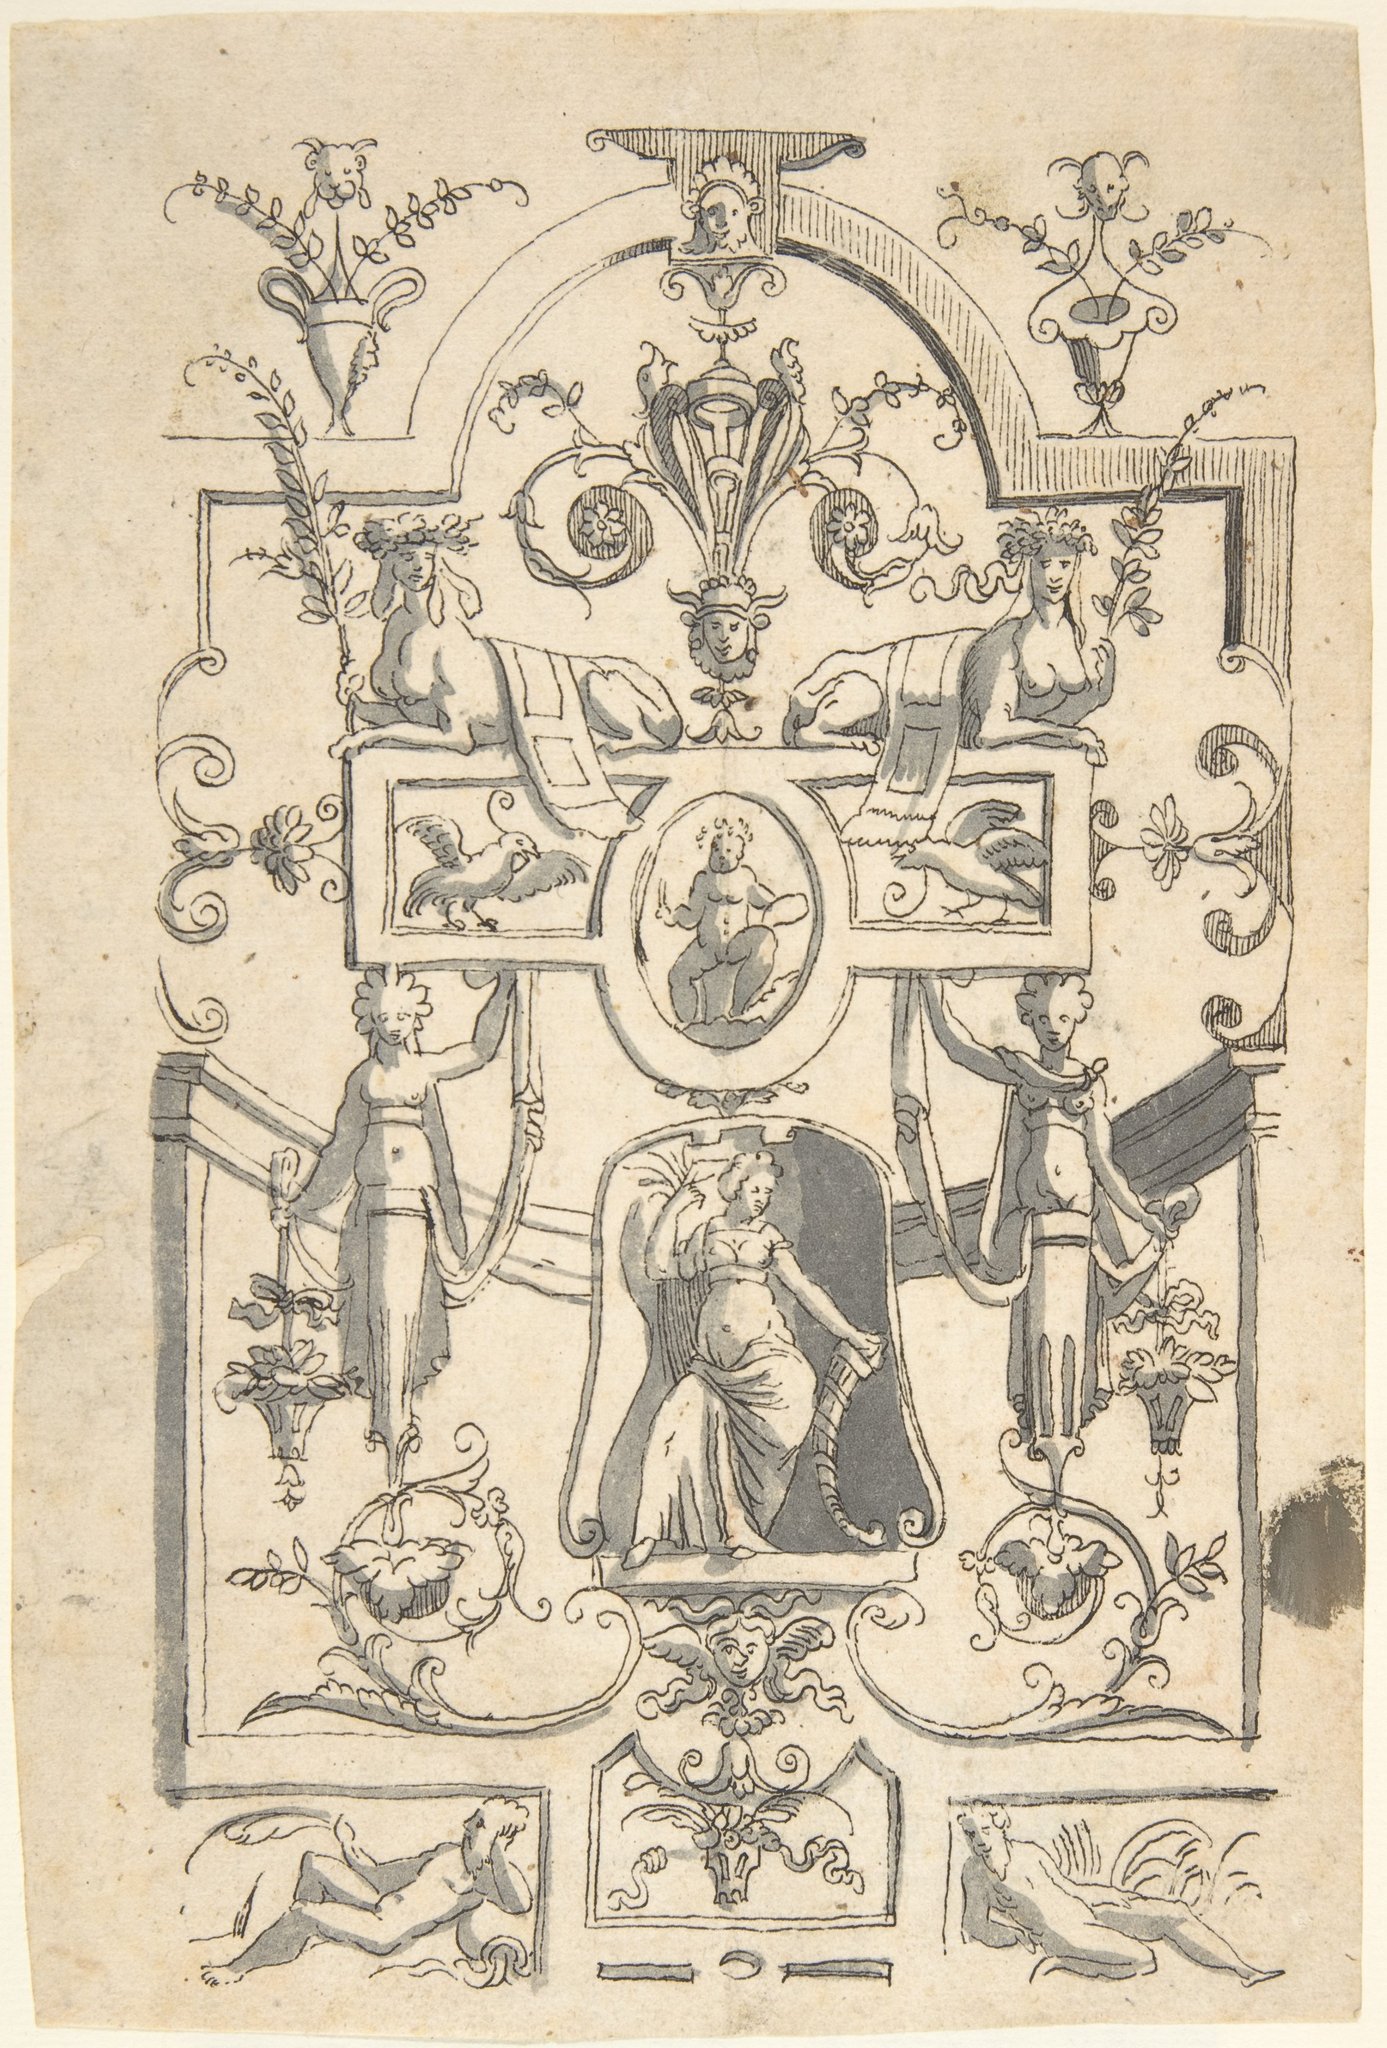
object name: ornament architecture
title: Candelabra Grotesque with a Female Figure in a Niche and Two Sphinxes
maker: anonymous, italian, 16th century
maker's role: artist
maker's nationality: italian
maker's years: 1500-1600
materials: ink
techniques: brush, pen, wash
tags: grotesques,ornament,women,sphinx